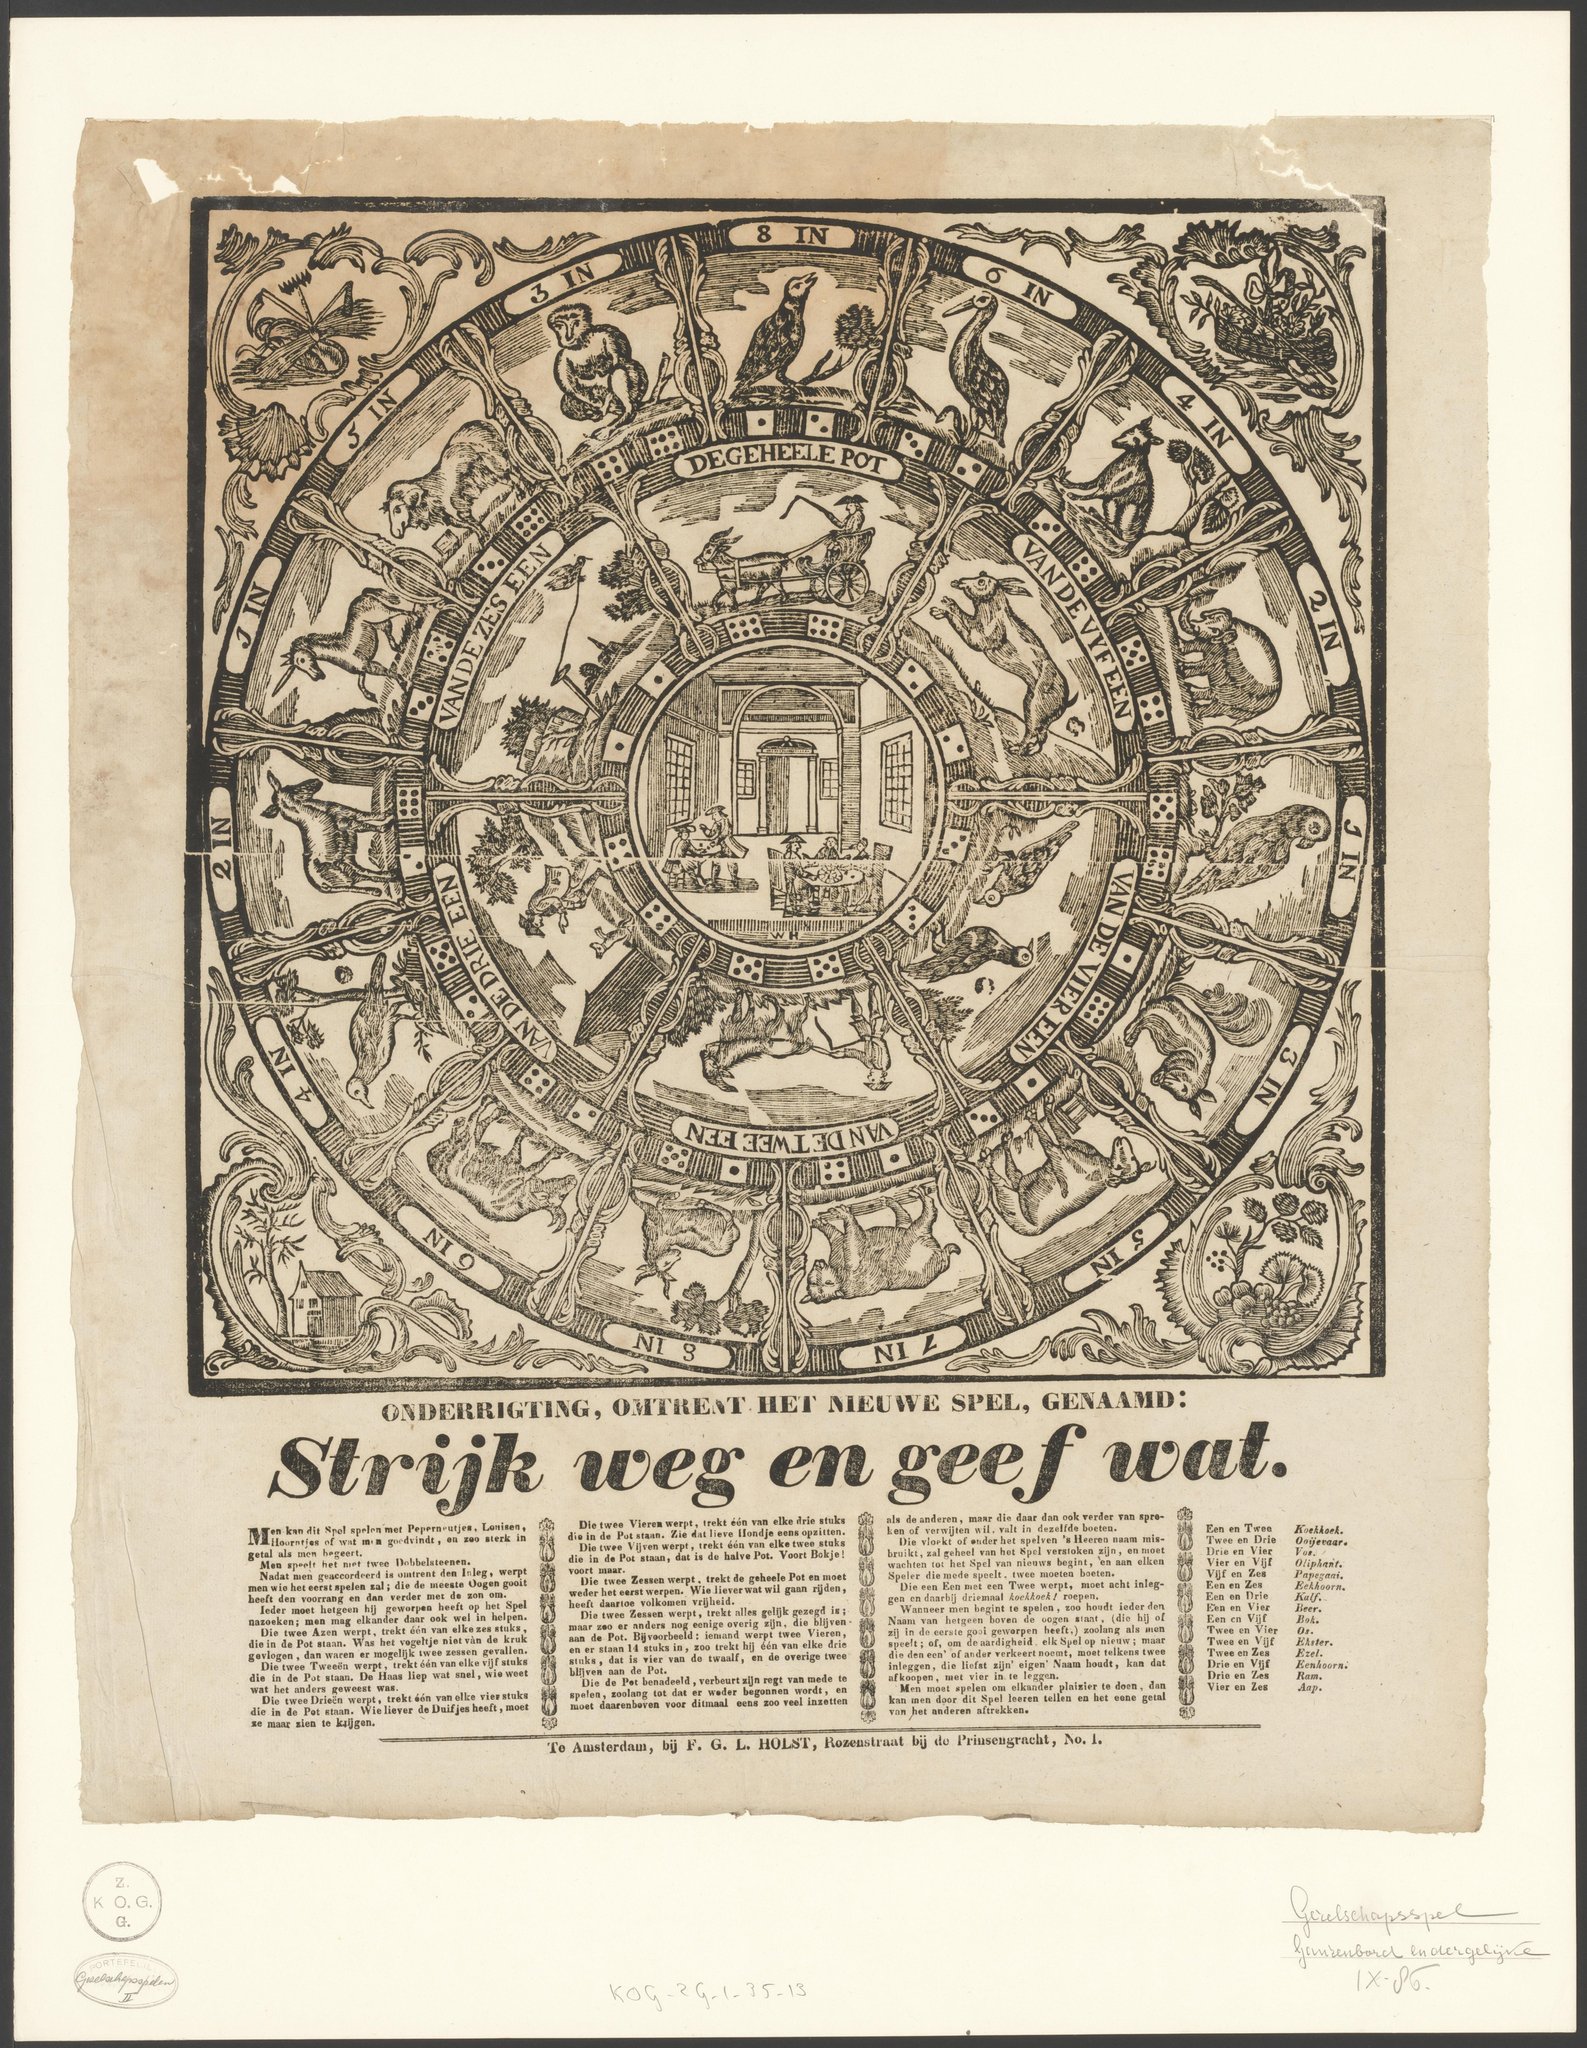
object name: print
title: Strijk weg en geef wat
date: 1861-1864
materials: paper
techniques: letterpress printing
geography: amsterdam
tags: animals, board-games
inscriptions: collector's mark: Lugt 1641, stamp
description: Een dobbelspel met in het middenveld een afbeelding van een kamer waarin twee mannen aan het dobbelen zijn en drie mensen een bordspel spelen. Hierom heen twee concentrische cirkels met afbeeldingen van dieren. In de hoeken symbolen van de vier jaargetijden. Onder het spel de spelregels. Onderwerpsrubrieken binnen de Atlas Zeden en Gewoonten: Zeden en gewoonten in engeren zin, Spel en vermaak, Gezelschapsspel II, Ganzenbord en dergelijke.